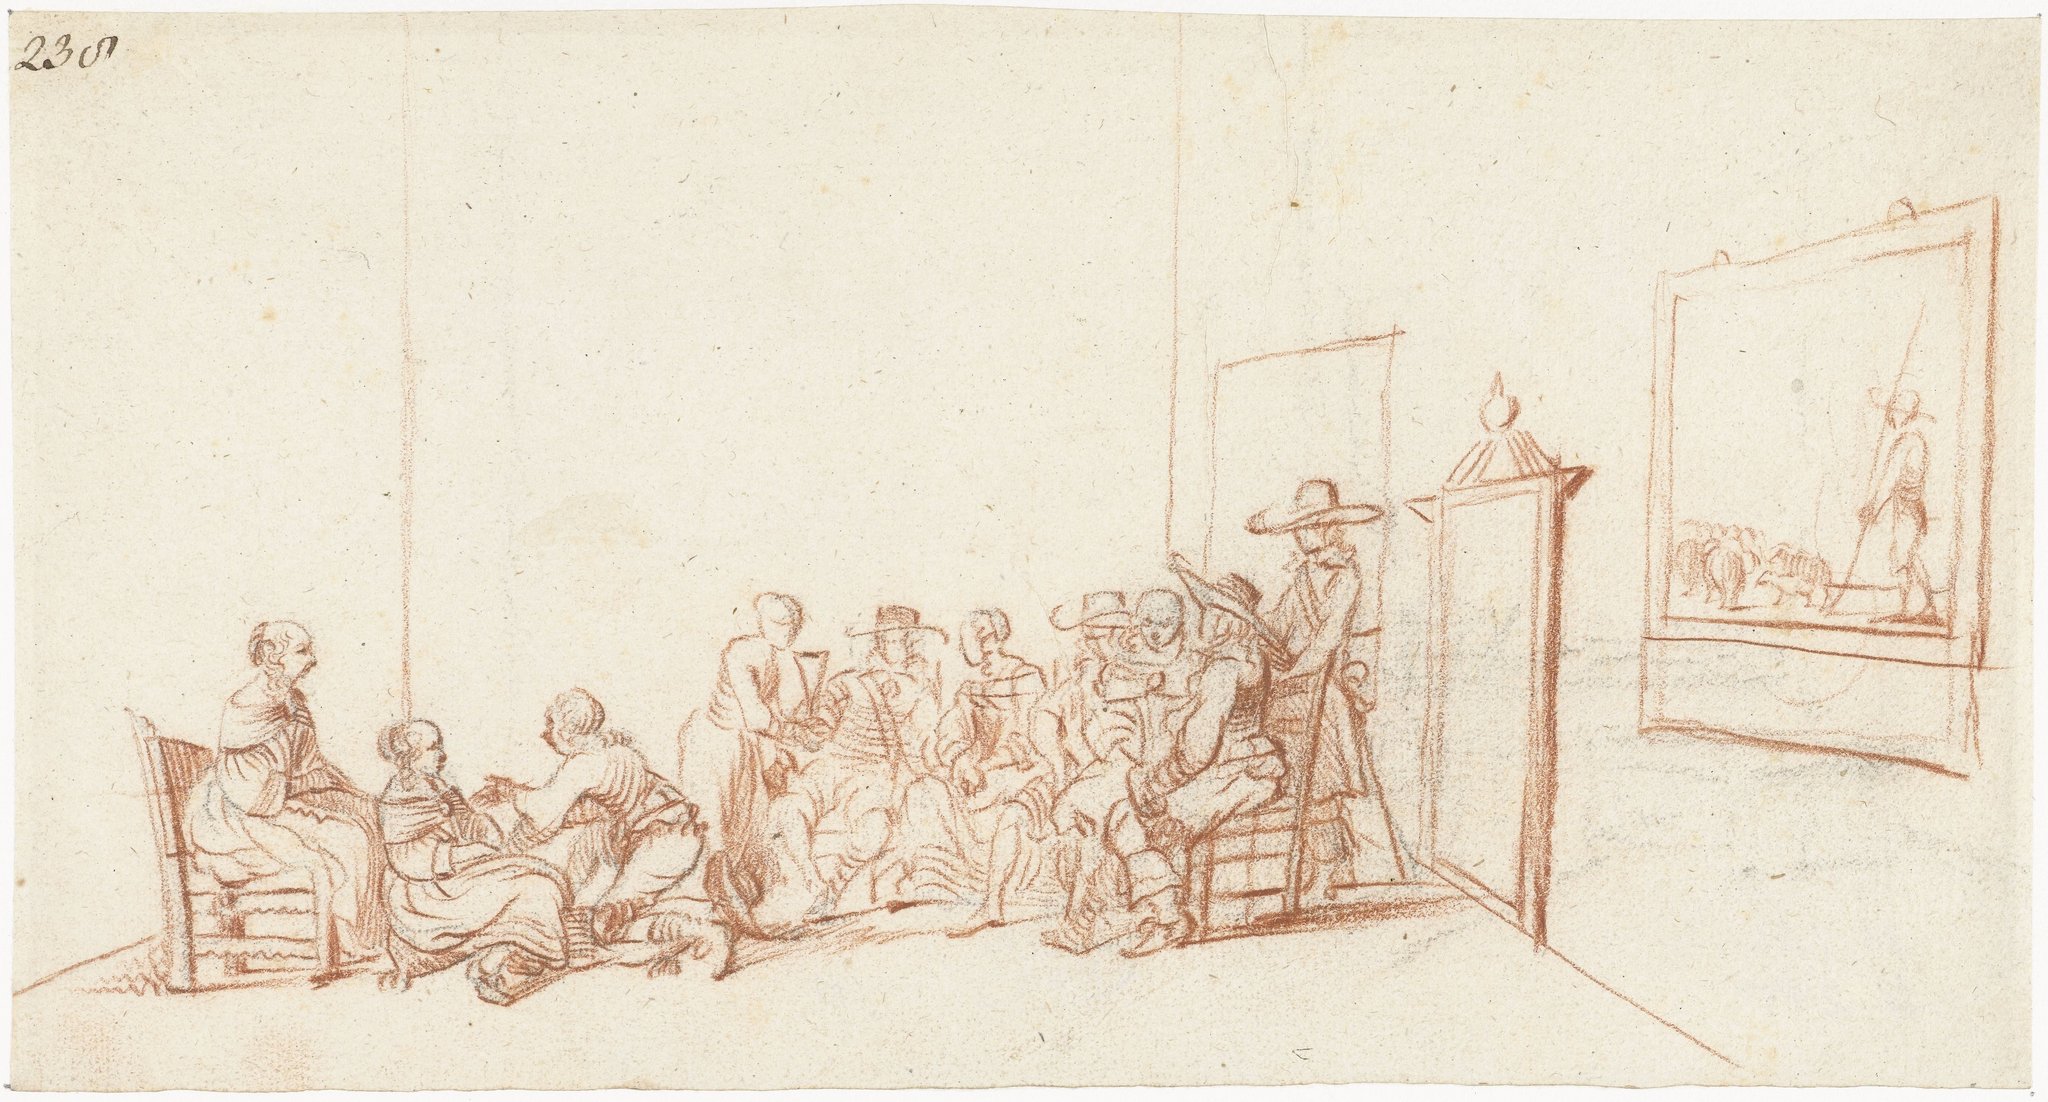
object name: drawing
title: Vrolijk gezelschap van tien mensen in een interieur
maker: gesina ter borch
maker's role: draughtsman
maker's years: 1633-1690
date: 1655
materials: chalk, paper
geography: zwolle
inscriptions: watermark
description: Vrolijk gezelschap van tien mensen in een interieur met een pastorale afbeelding aan de muur.